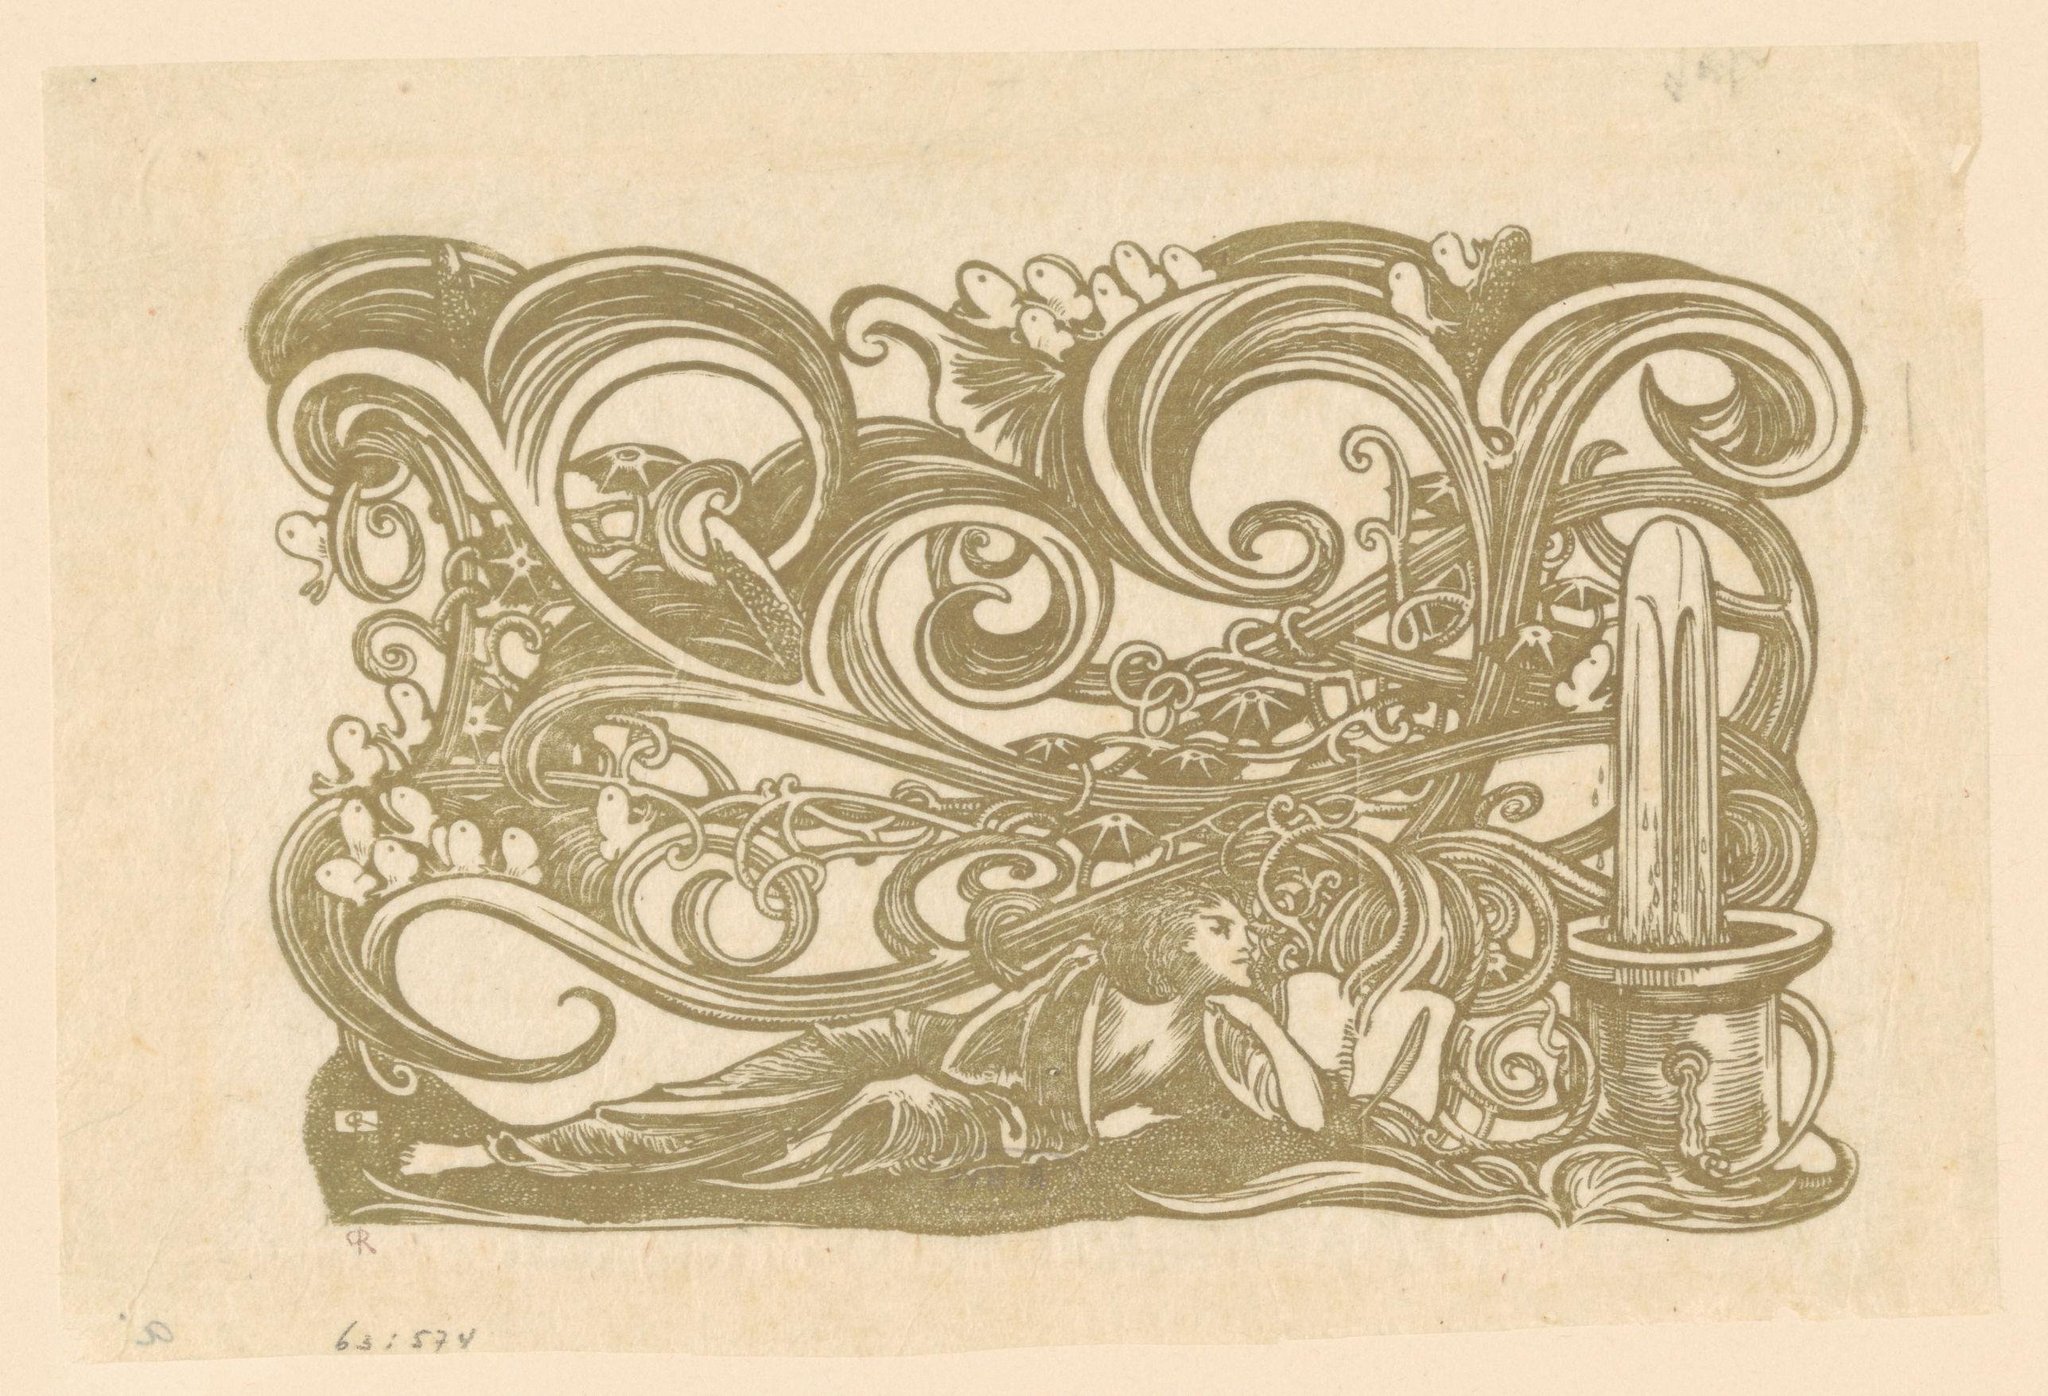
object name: print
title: Figuur bij fontein met ornamentele ranken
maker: charles ricketts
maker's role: print maker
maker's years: 1866-1931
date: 1892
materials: paper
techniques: woodcut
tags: ornaments ~ art, ornamental fountain, lying figure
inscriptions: collector's mark: Lugt 2228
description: Proefdruk in goud/groen voor een illustratie bij 'The Unwritten Book' in The Dial 2 (1892), p. 25.